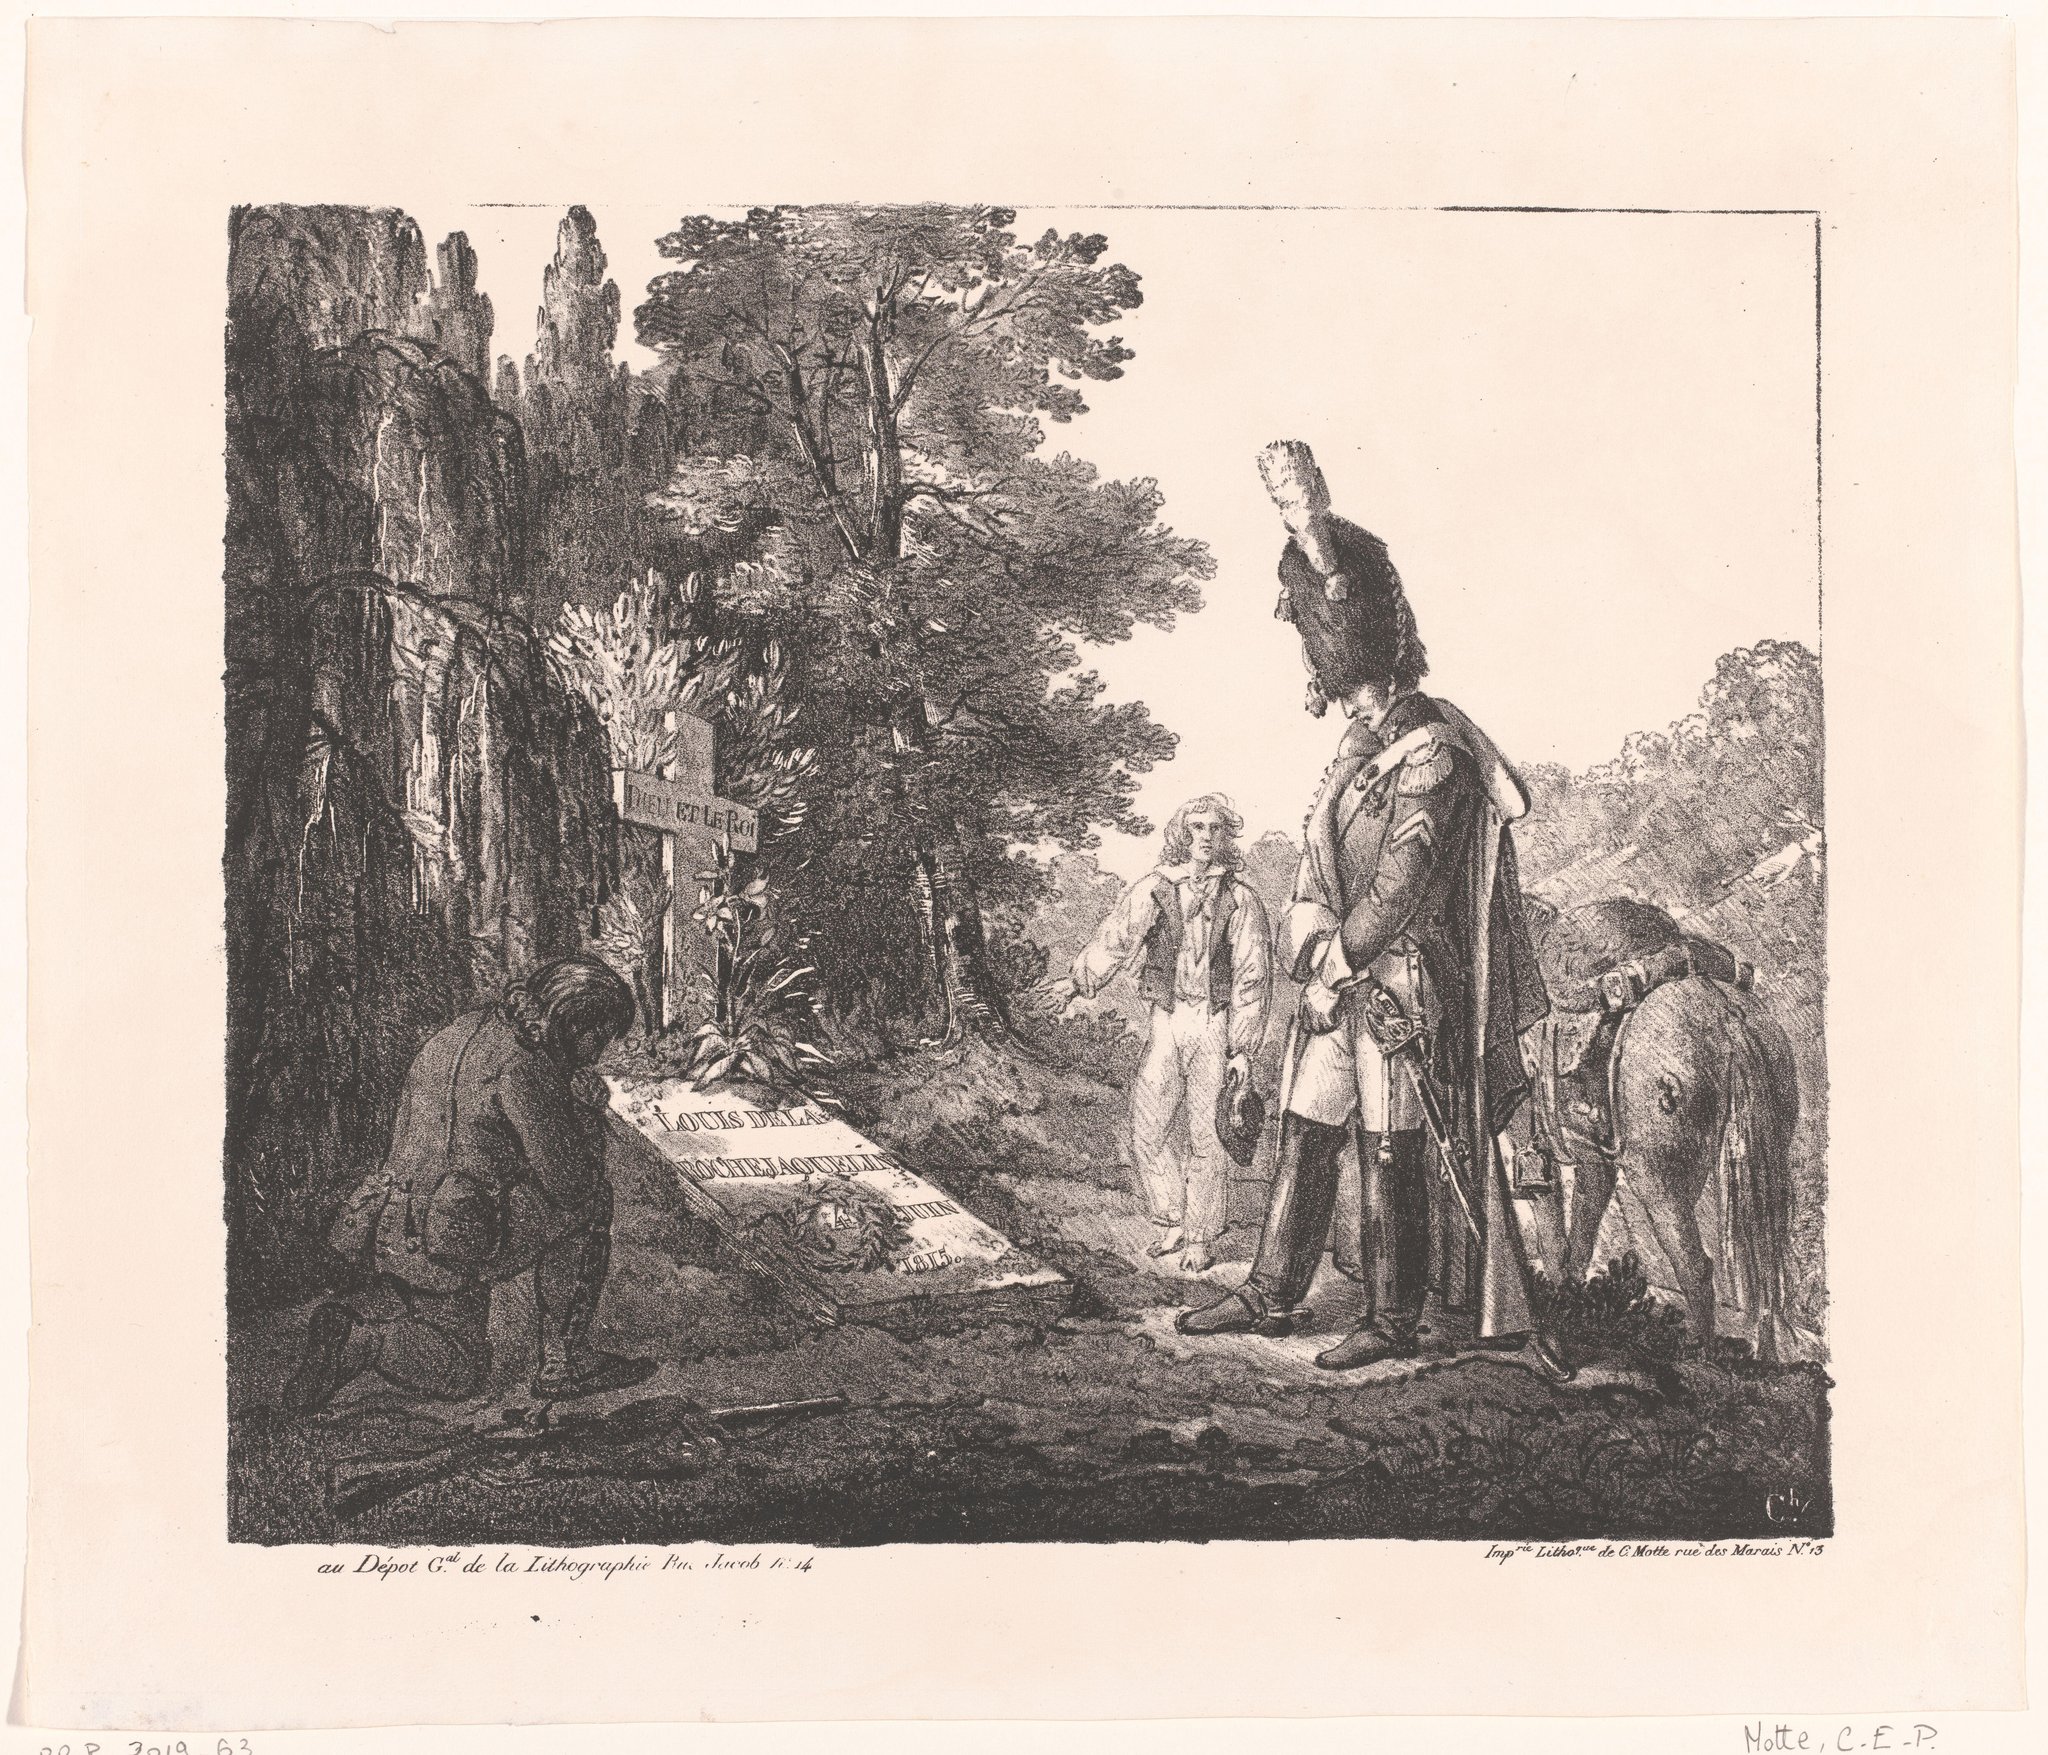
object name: print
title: Soldaat bij het grafmonument van generaal Louis du Vergier de la Rochejaquelein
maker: charles etienne pierre motte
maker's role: print maker, printer, publisher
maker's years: 1785-1836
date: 1815-1818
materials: paper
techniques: lithograph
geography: paris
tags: gravestone, tombstone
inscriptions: signature: ‘Ch./’, collector's mark: Lugt 2760, collector's mark: Lugt 2228, : ‘au Dépot G.al de la Lithographie Rue Jacob No. 14’